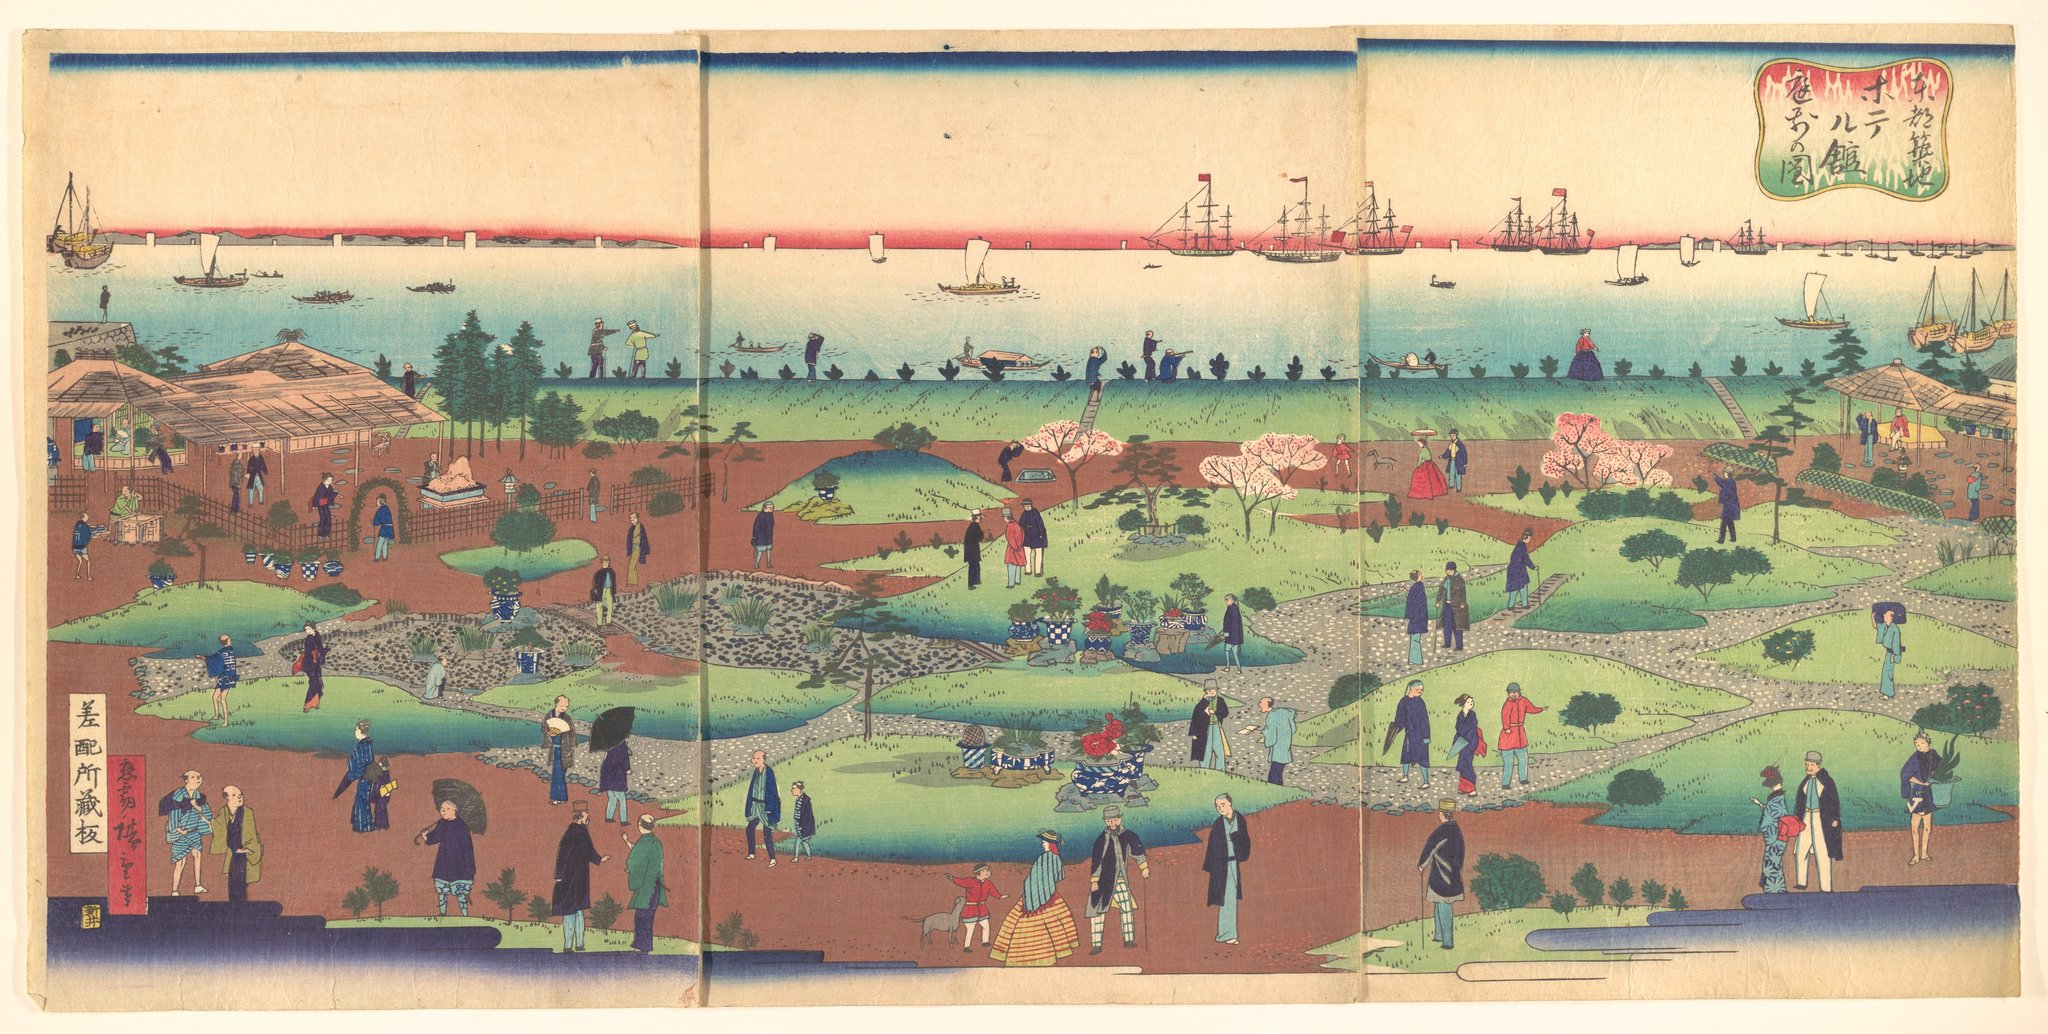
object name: print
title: Illustration of the Front Garden of the Tsukiji Hotel in the Eastern Capital (Tōto Tsukiji hoteru kan niwa mae no zu)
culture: japanese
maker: utagawa hiroshige iii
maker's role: artist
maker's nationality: japanese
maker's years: 1843-1894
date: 1868-1872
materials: ink, paper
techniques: woodblock print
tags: gardens,men,women,boats